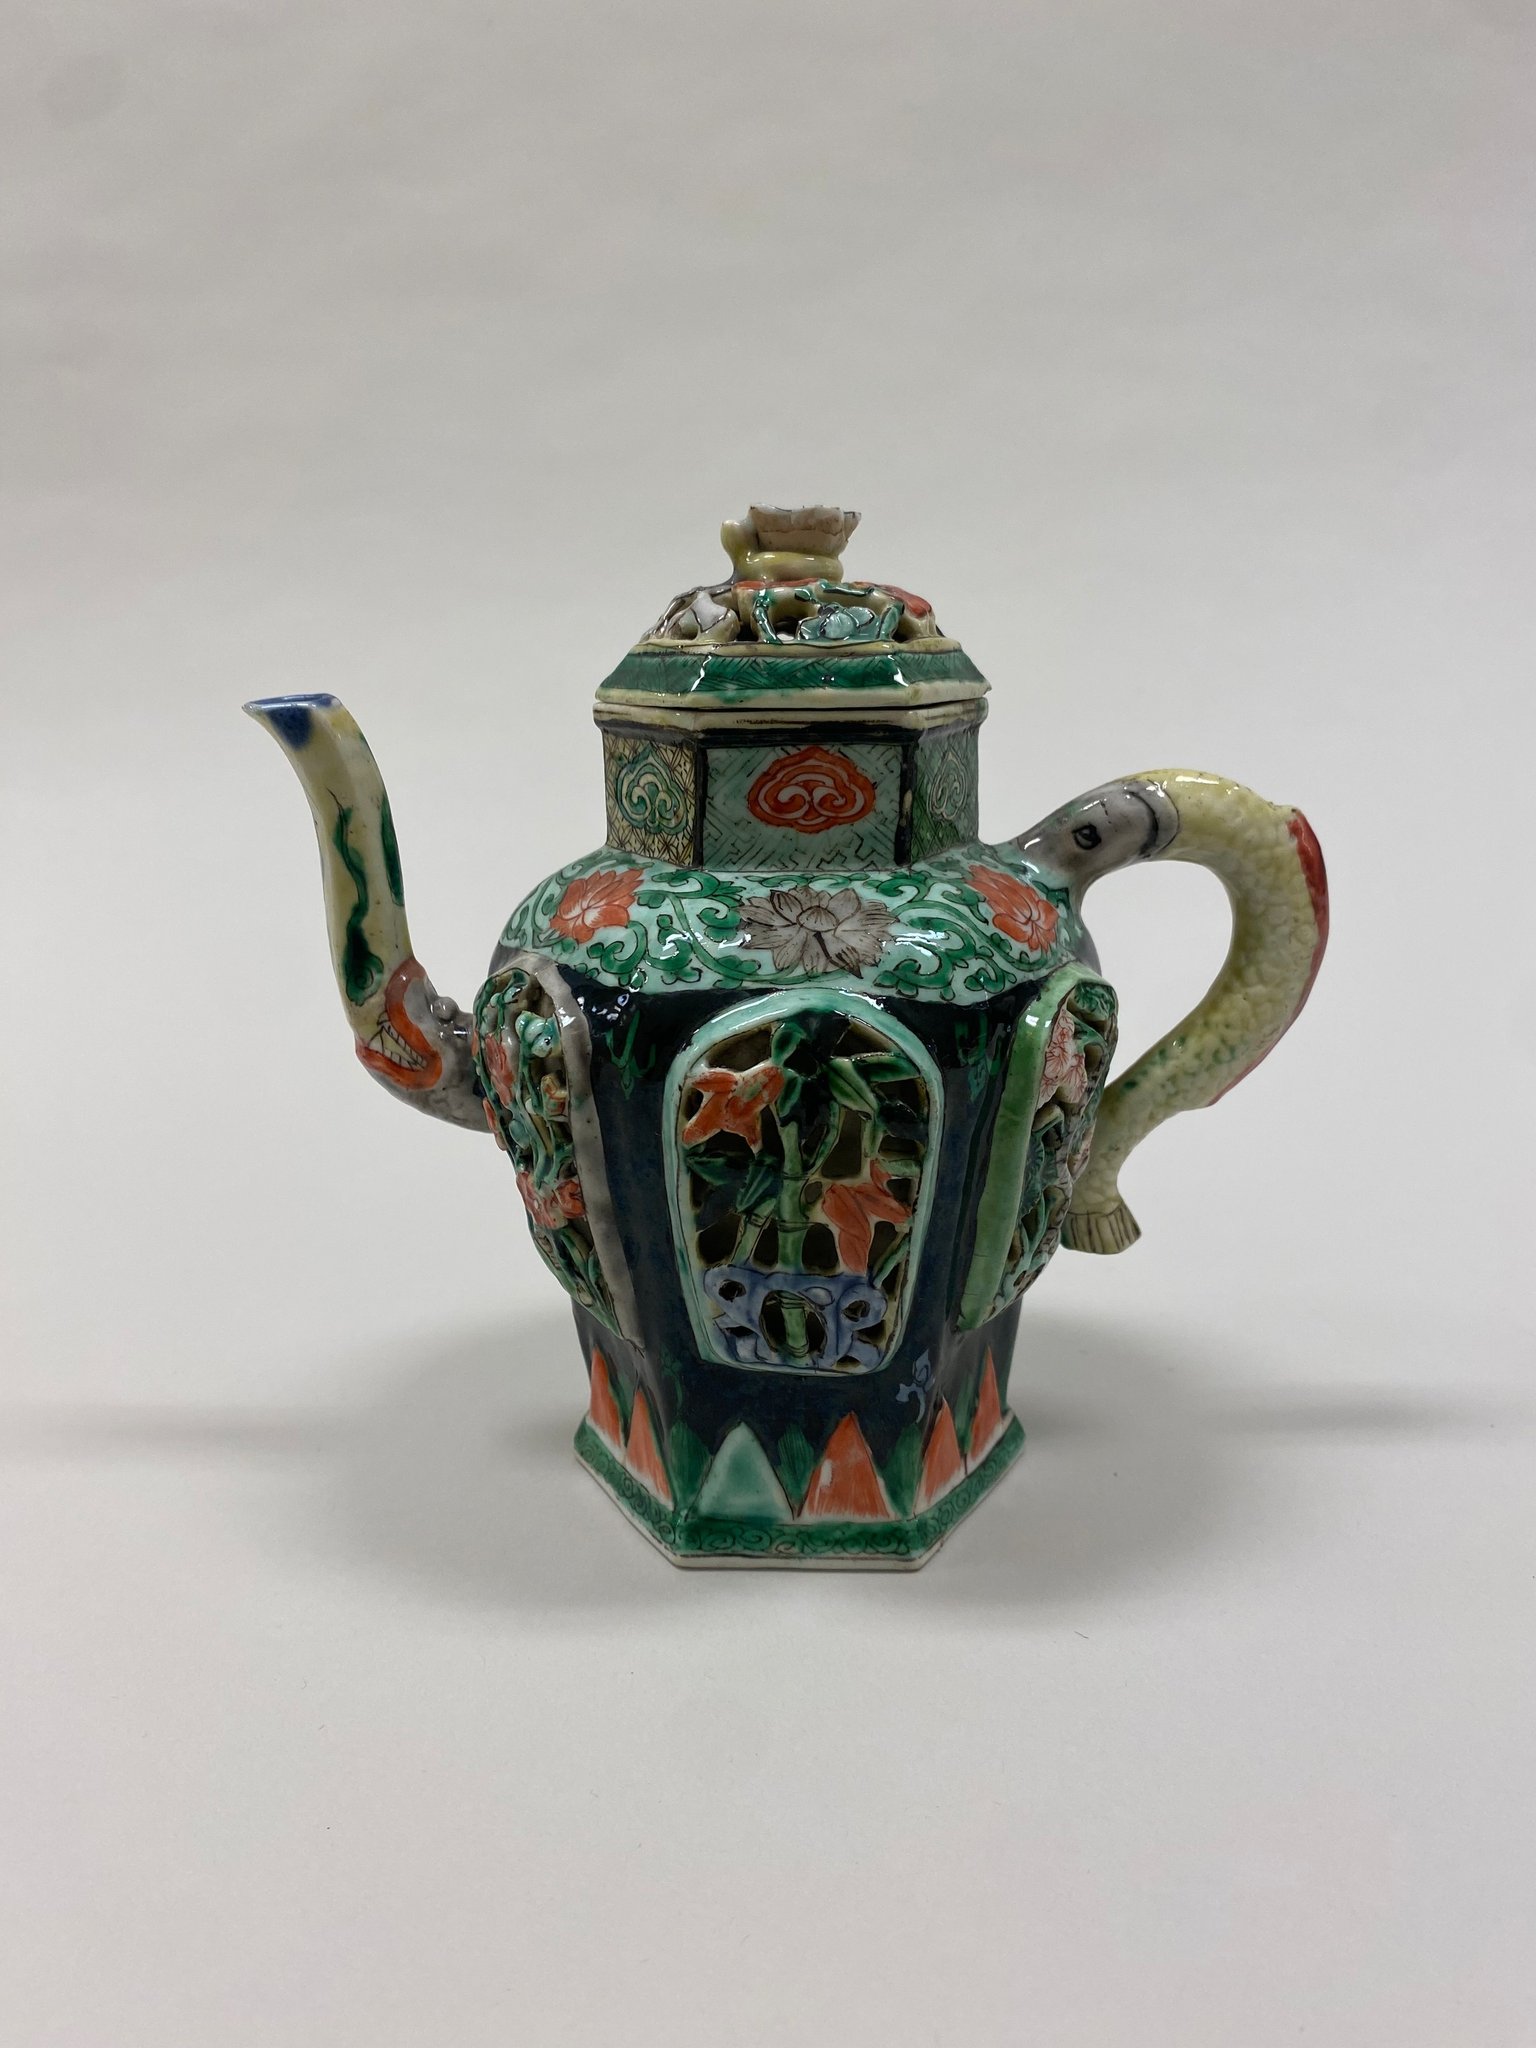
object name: ewer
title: Hexagonal ewer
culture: chinese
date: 1801-1900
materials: enamel, porcelain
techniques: overglaze, painting, polychrome